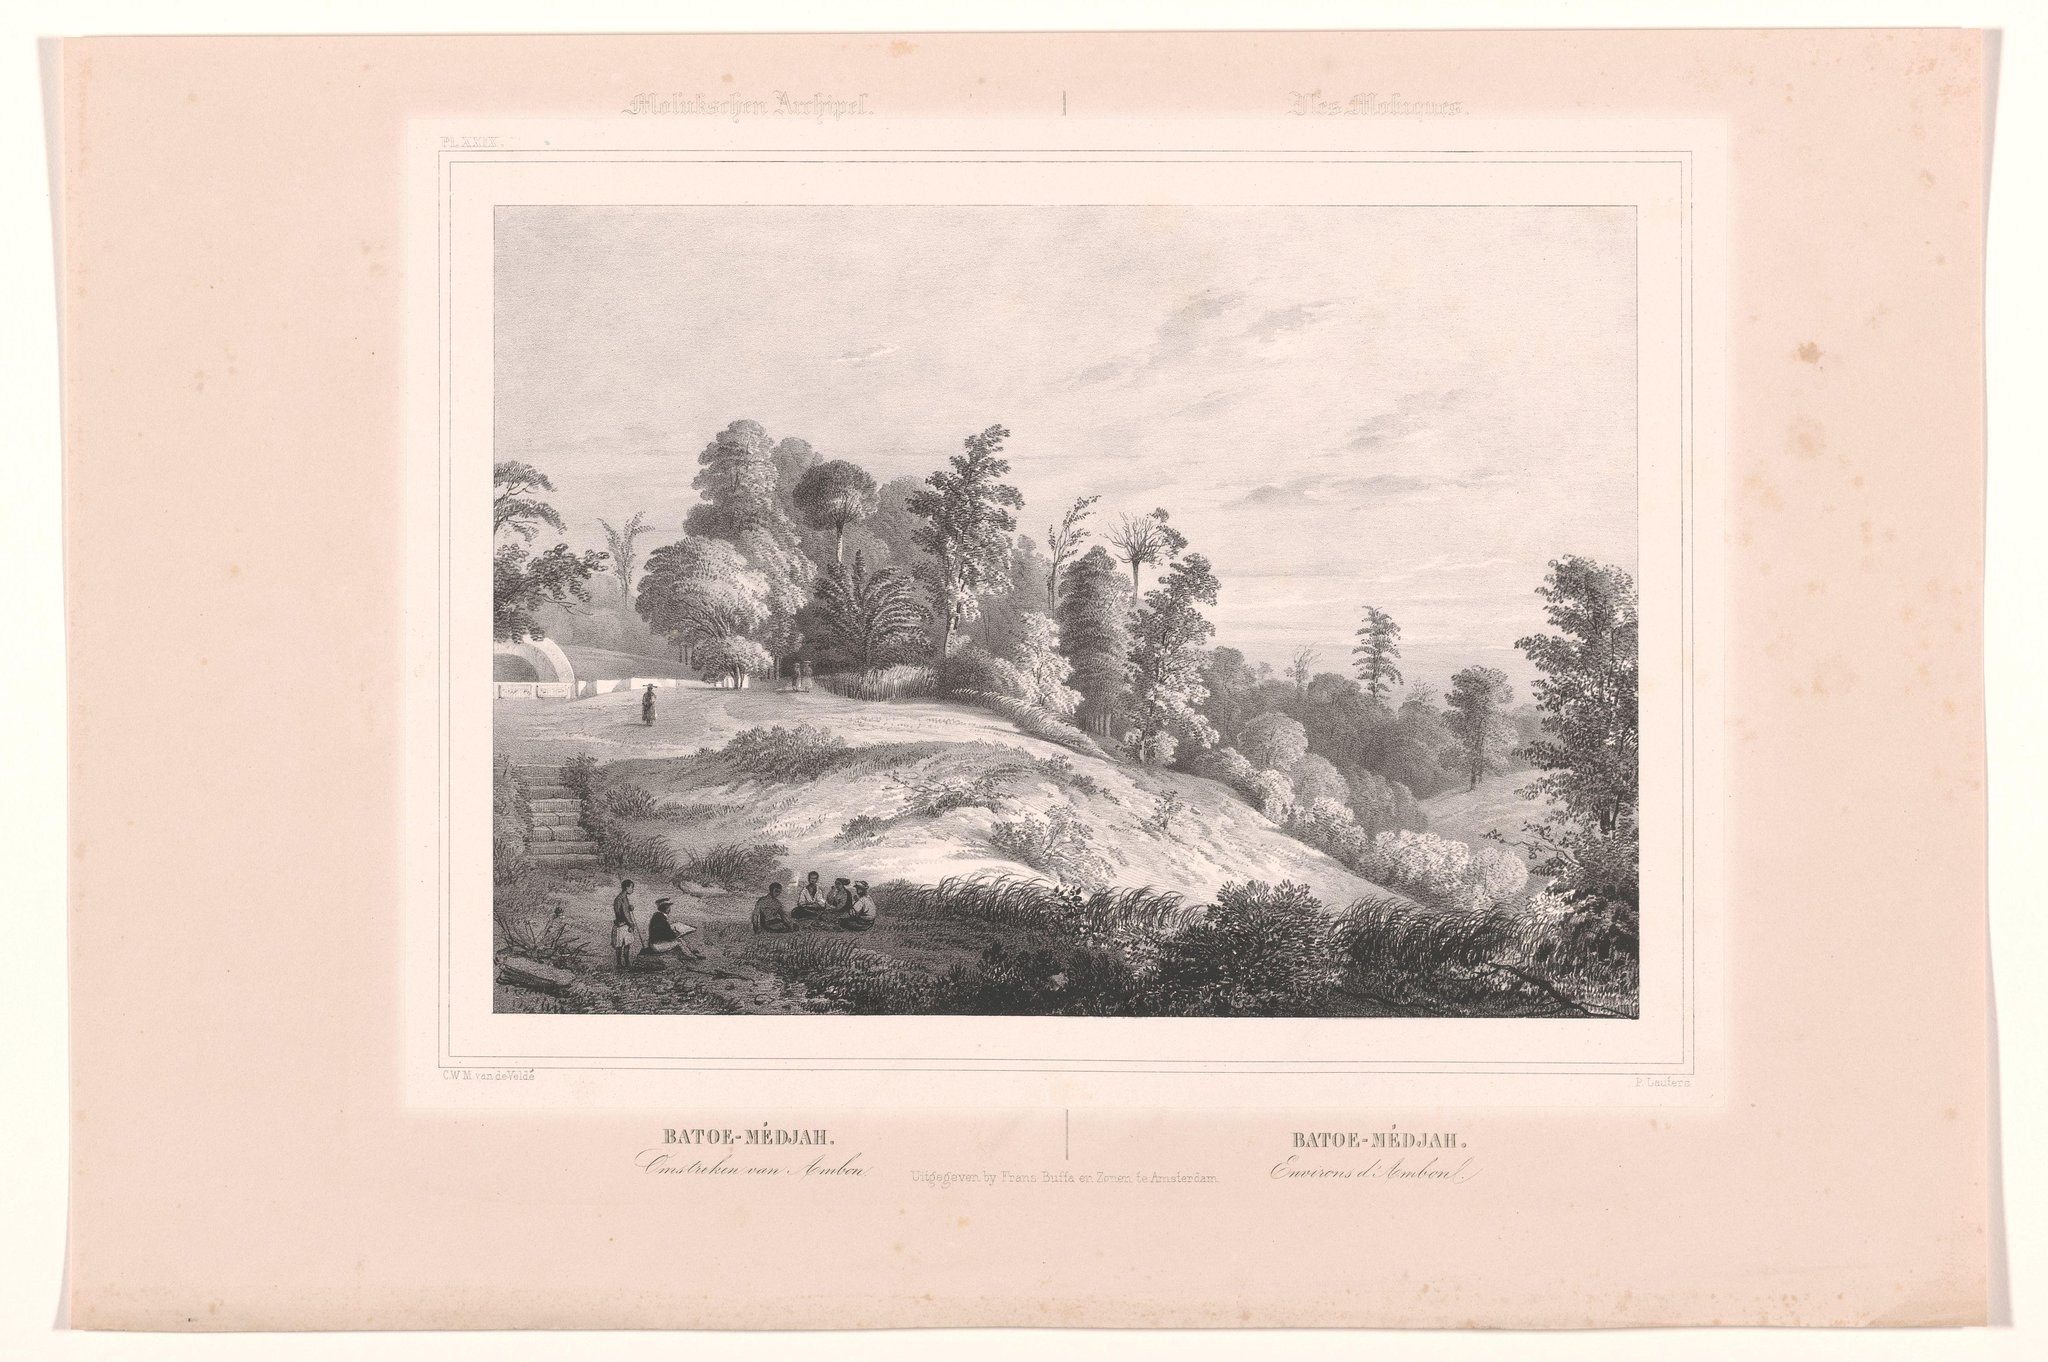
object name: print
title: Gezicht op de heuvel Batu Medjah in Ambon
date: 1843-1845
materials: paper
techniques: lithograph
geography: brussels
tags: low hill country (+ landscape with figures, staffage), landscapes in the non-temperate zone, exotic landscapes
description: Links in het landschap zitten figuren. Genummerd linksboven: Pl. XXIX. De prent maakt deel uit van een omslag met elf bladen.